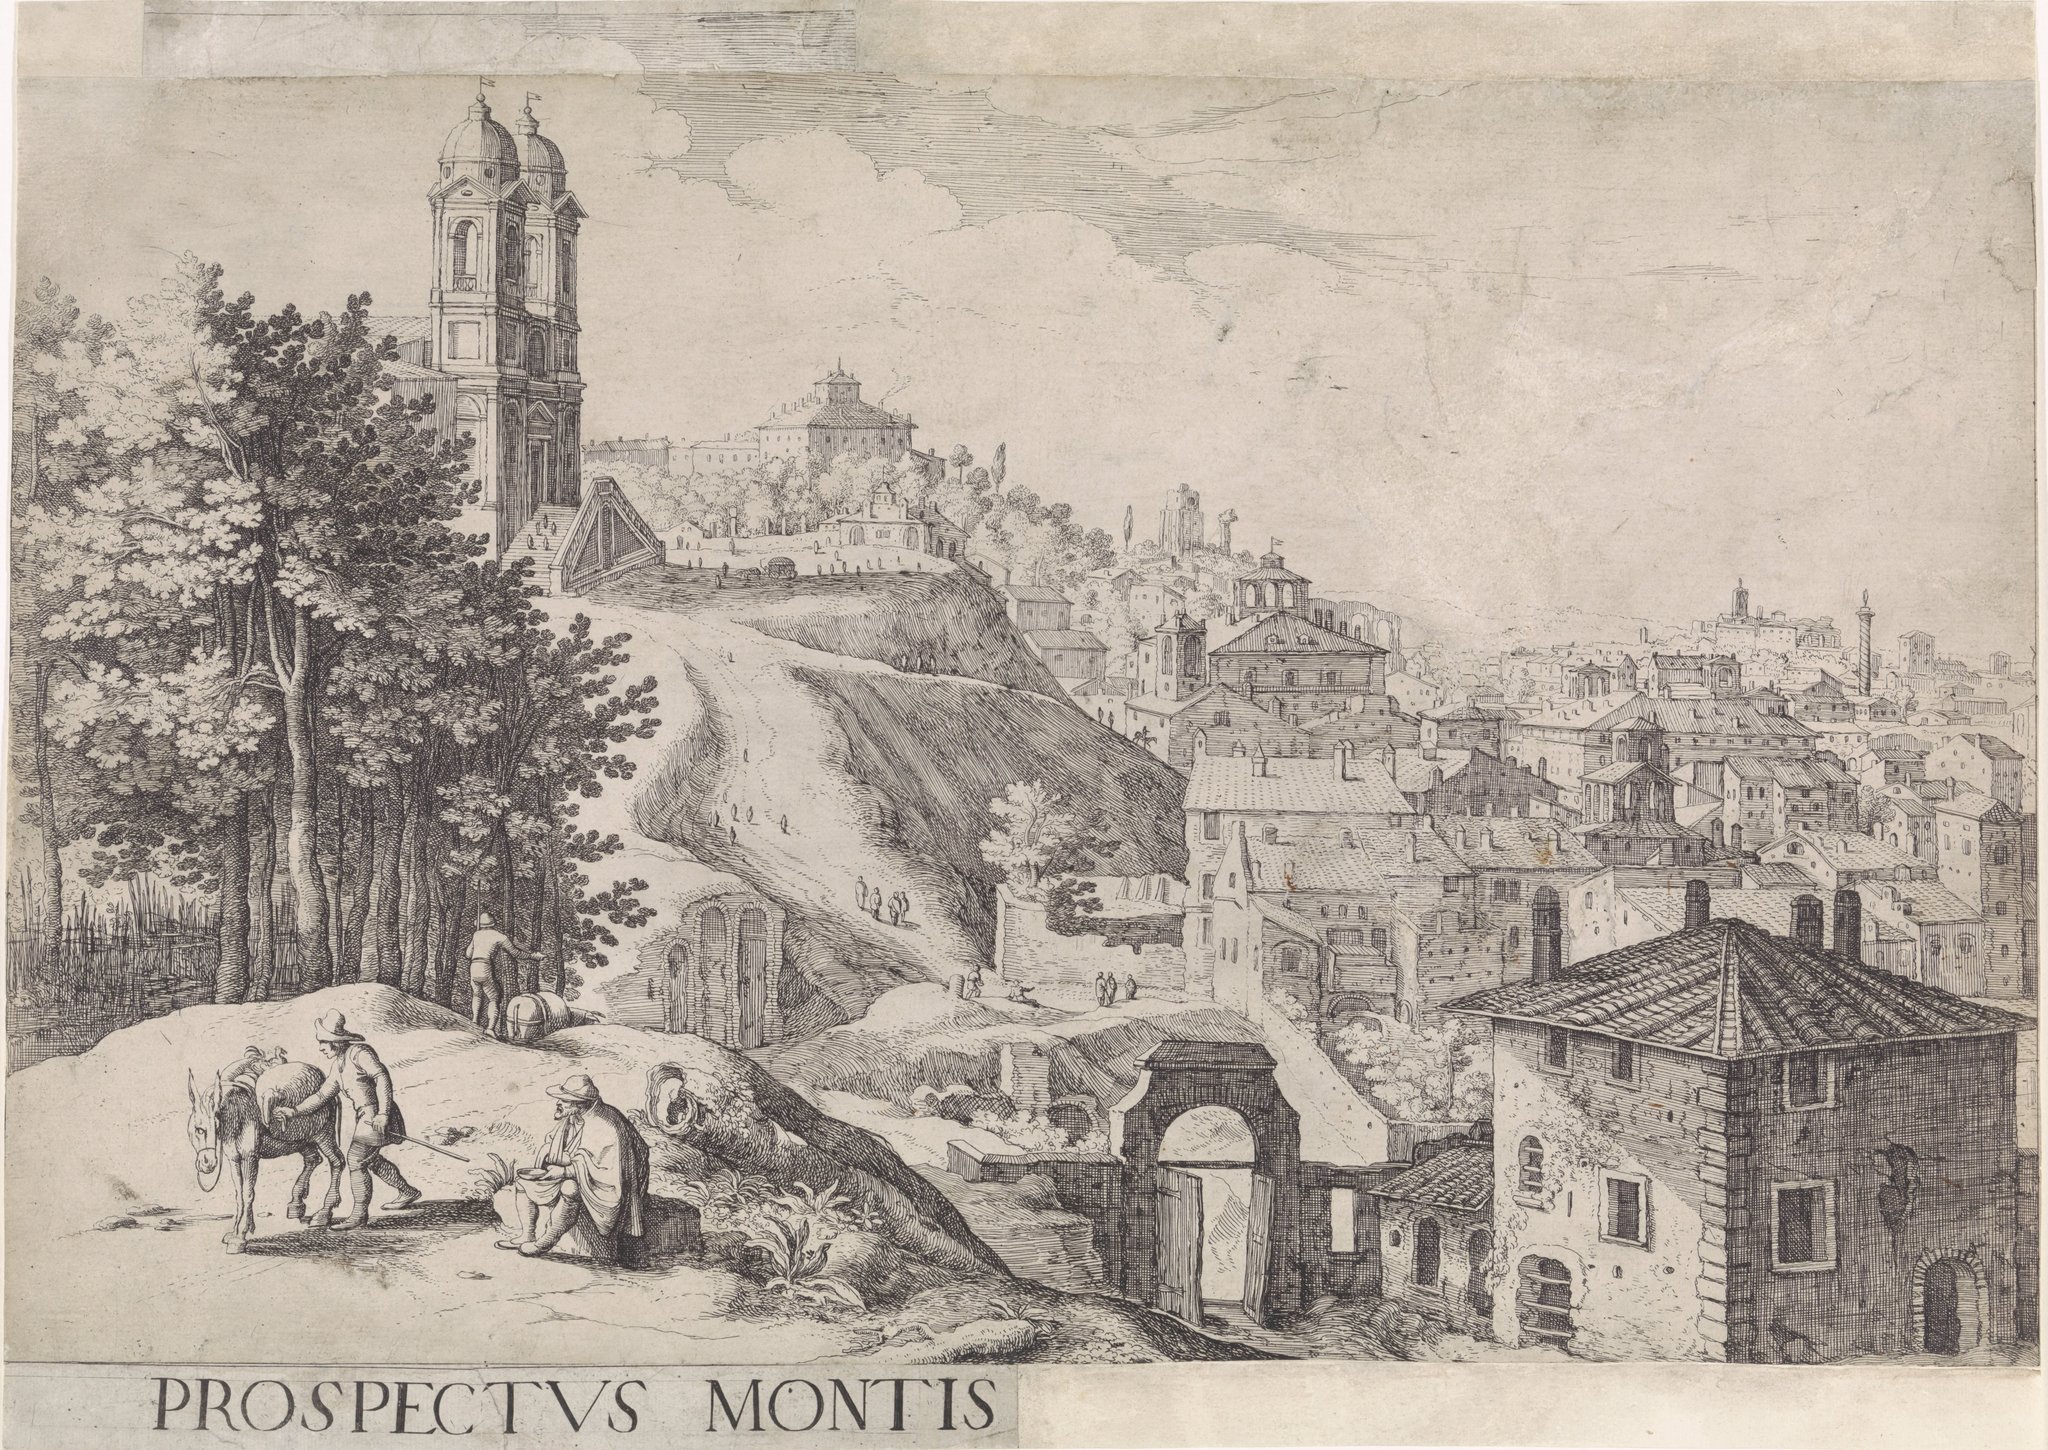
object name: print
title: Gezicht op Rome en de Trinità dei Monti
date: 1594-1635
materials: paper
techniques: engraving, etching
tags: city-view in general; 'veduta', church (exterior), beggar, rome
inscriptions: collector's mark: Lugt 2228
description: Gezicht op Rome met links de kerk Trinità dei Monti. Op de voorgrond zit een bedelaar aan de kant van de weg, waar een man met een ezel voorbij komt.